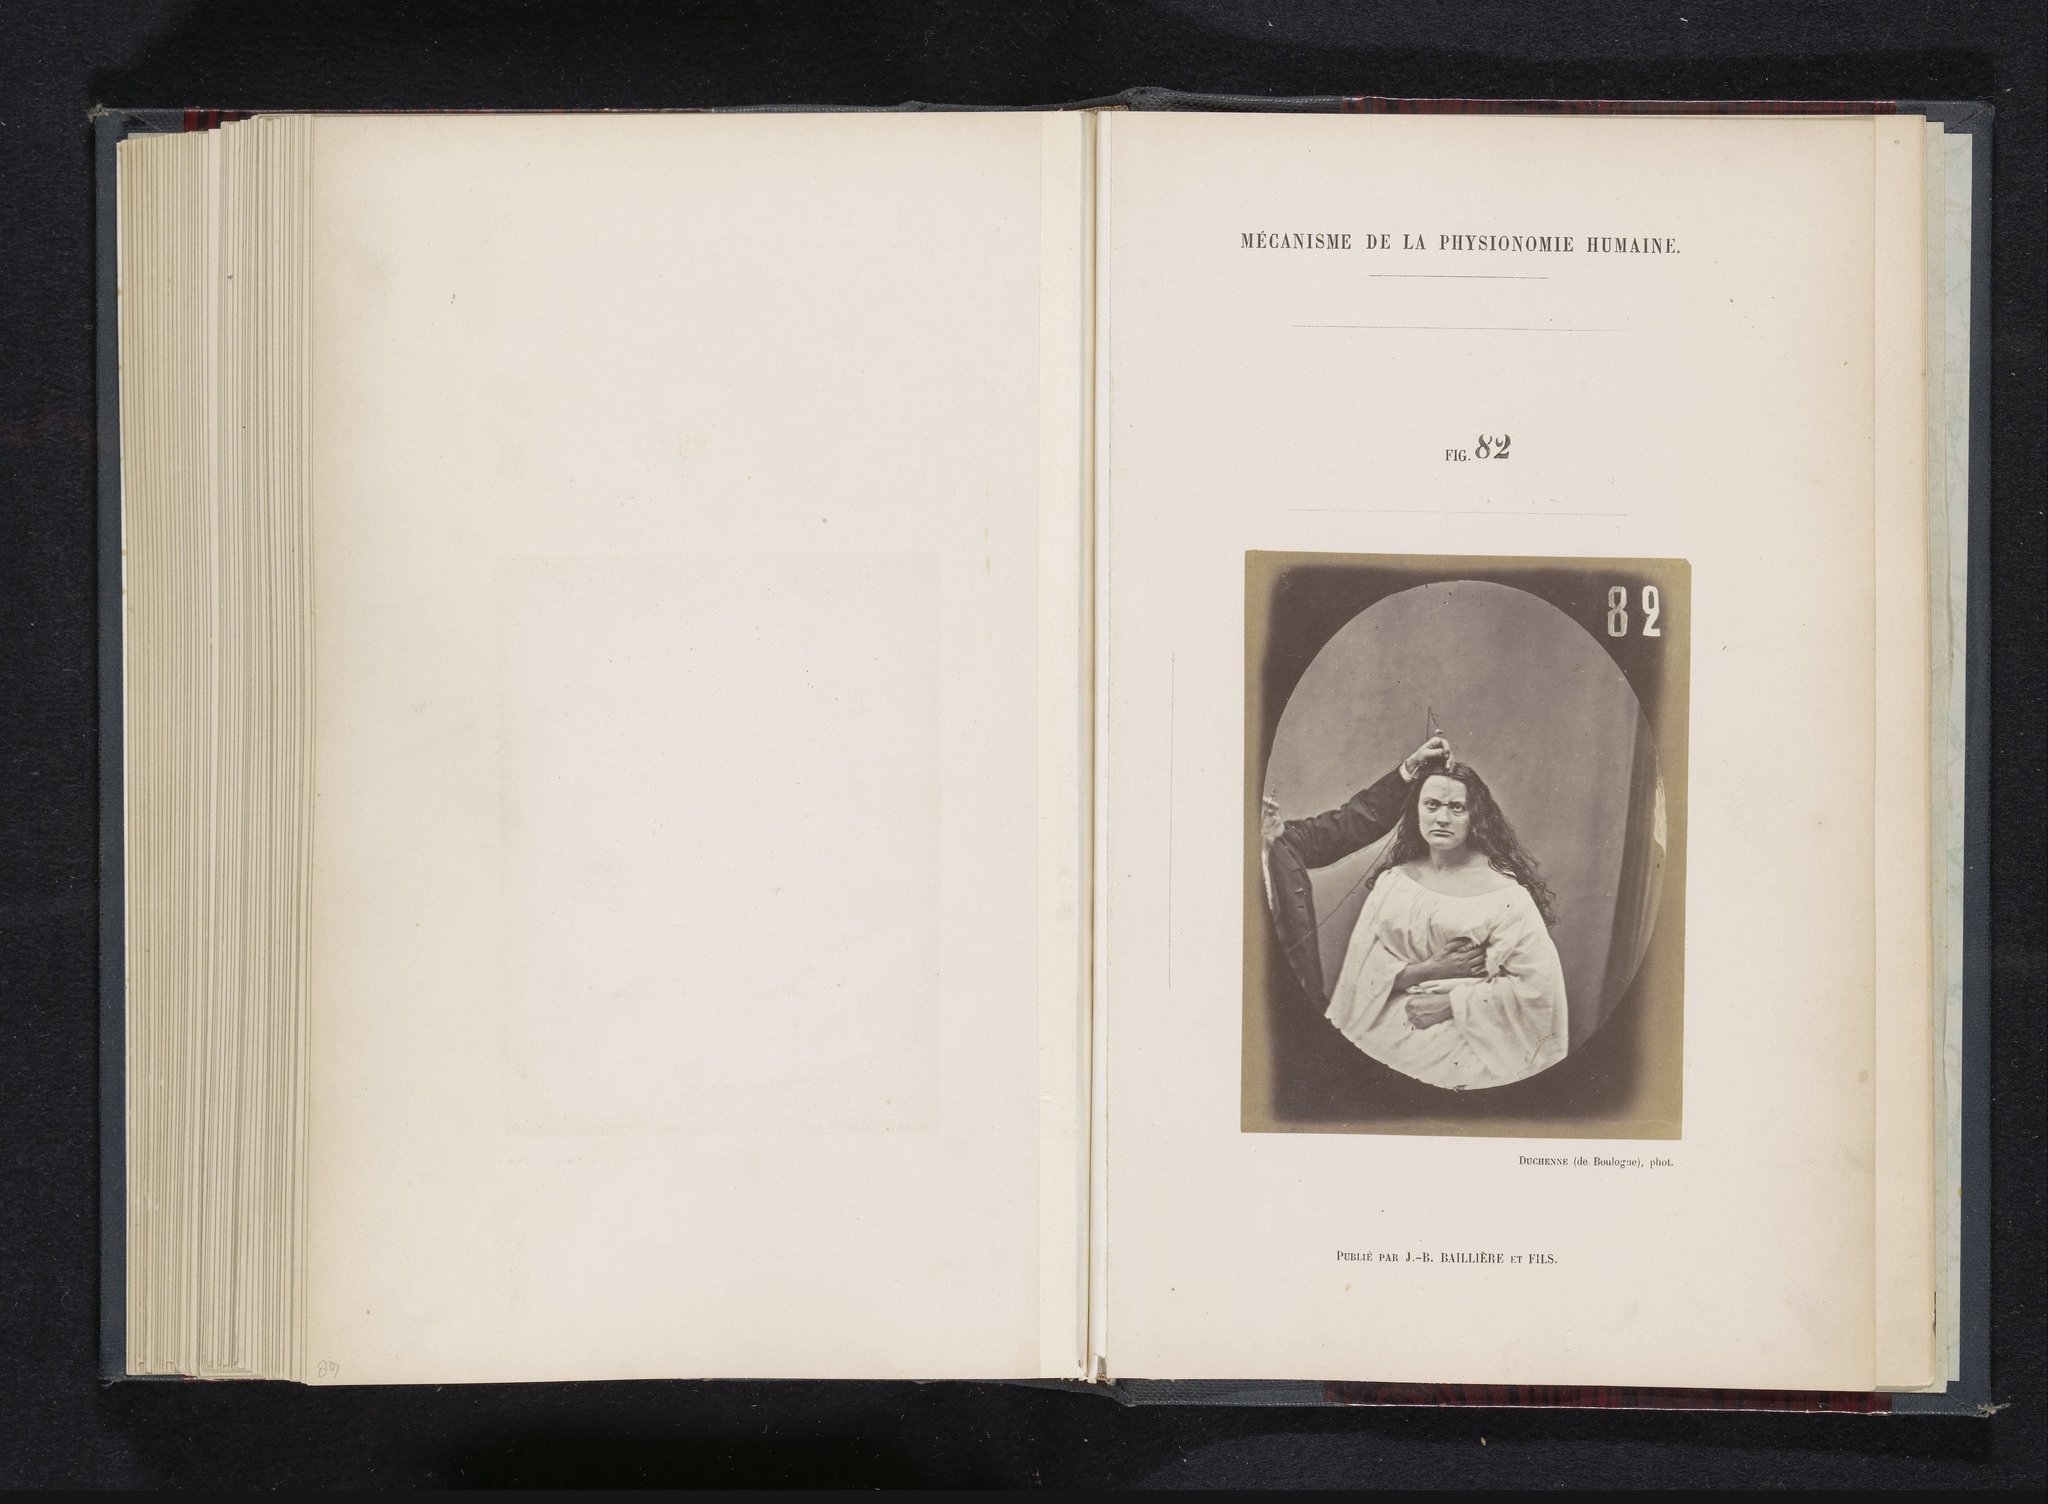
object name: photograph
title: Portret van een proefpersoon tijdens elektrostimulatie: 'Lady Macbeth'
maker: guillaume benjamin amand duchenne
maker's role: fotograaf, medicus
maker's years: 1806-1875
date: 1860-1862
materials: paper, photographic support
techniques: albumen print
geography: france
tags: face, adult woman, physiology and anatomy ~ nervous system, neurology, lady macbeth, physiology and anatomy, morphology of facial expression, physiognomy, experiment, test ~ science and technology, france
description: Ongenummerde pagina met foto 82 uit Mécanisme de la physionomie humaine ou analyse électro-physiologique de l'expression des passions (Atlas).